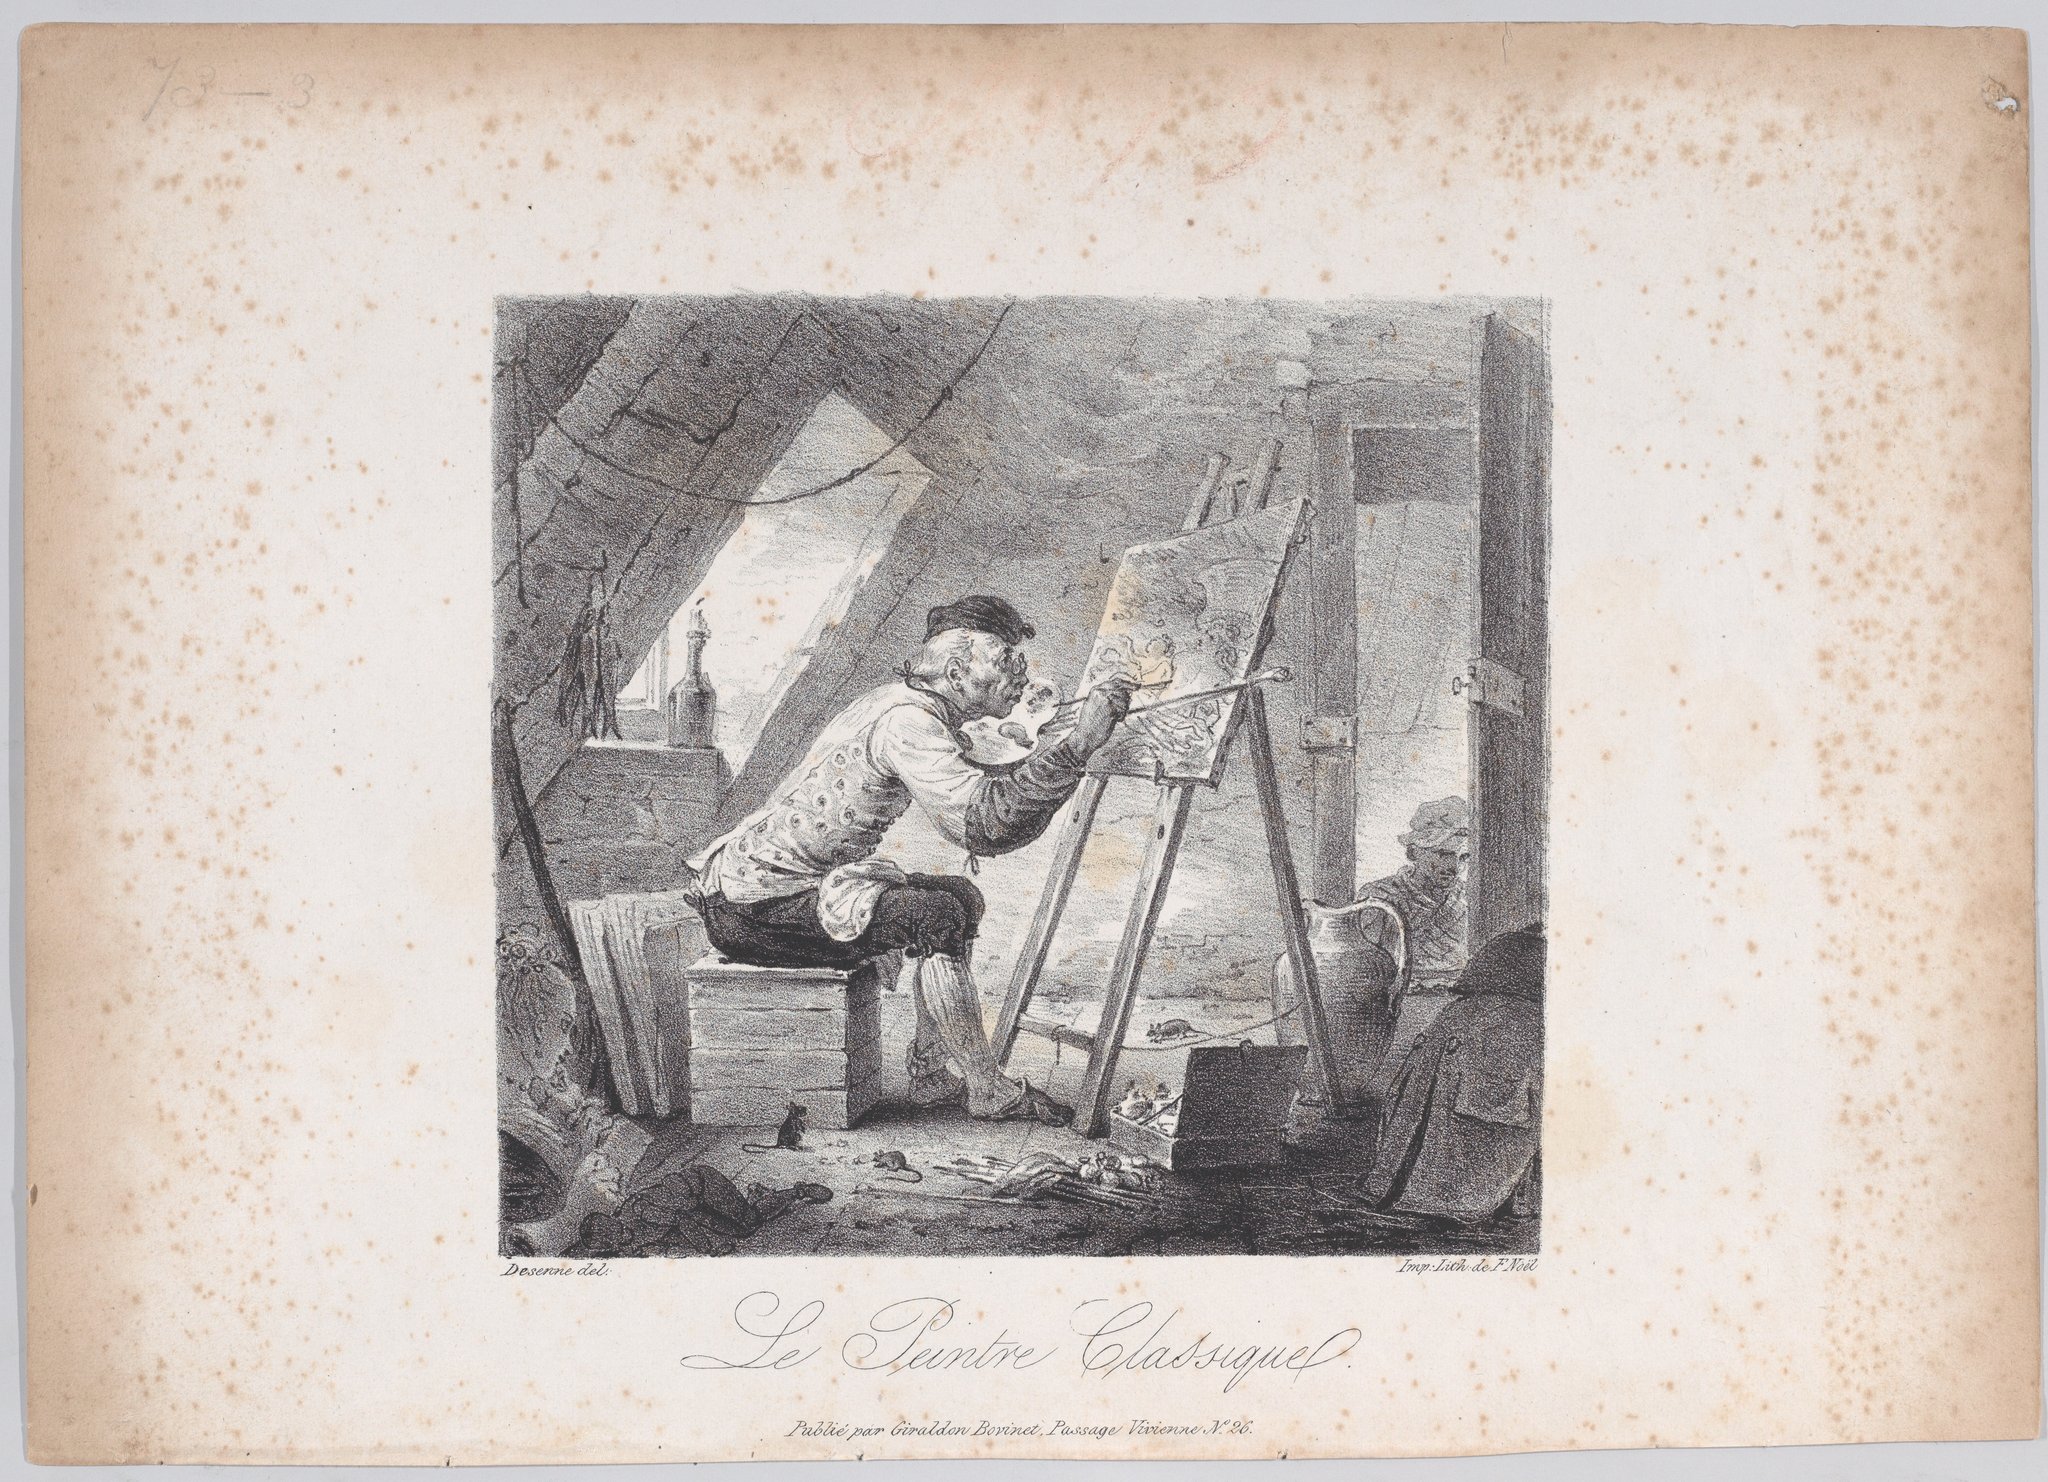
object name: print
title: Le Peintre Classique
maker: alexandre joseph desenne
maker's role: artist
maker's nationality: french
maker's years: 1785-1827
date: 1805-1827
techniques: lithograph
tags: painting,men,mice,artists